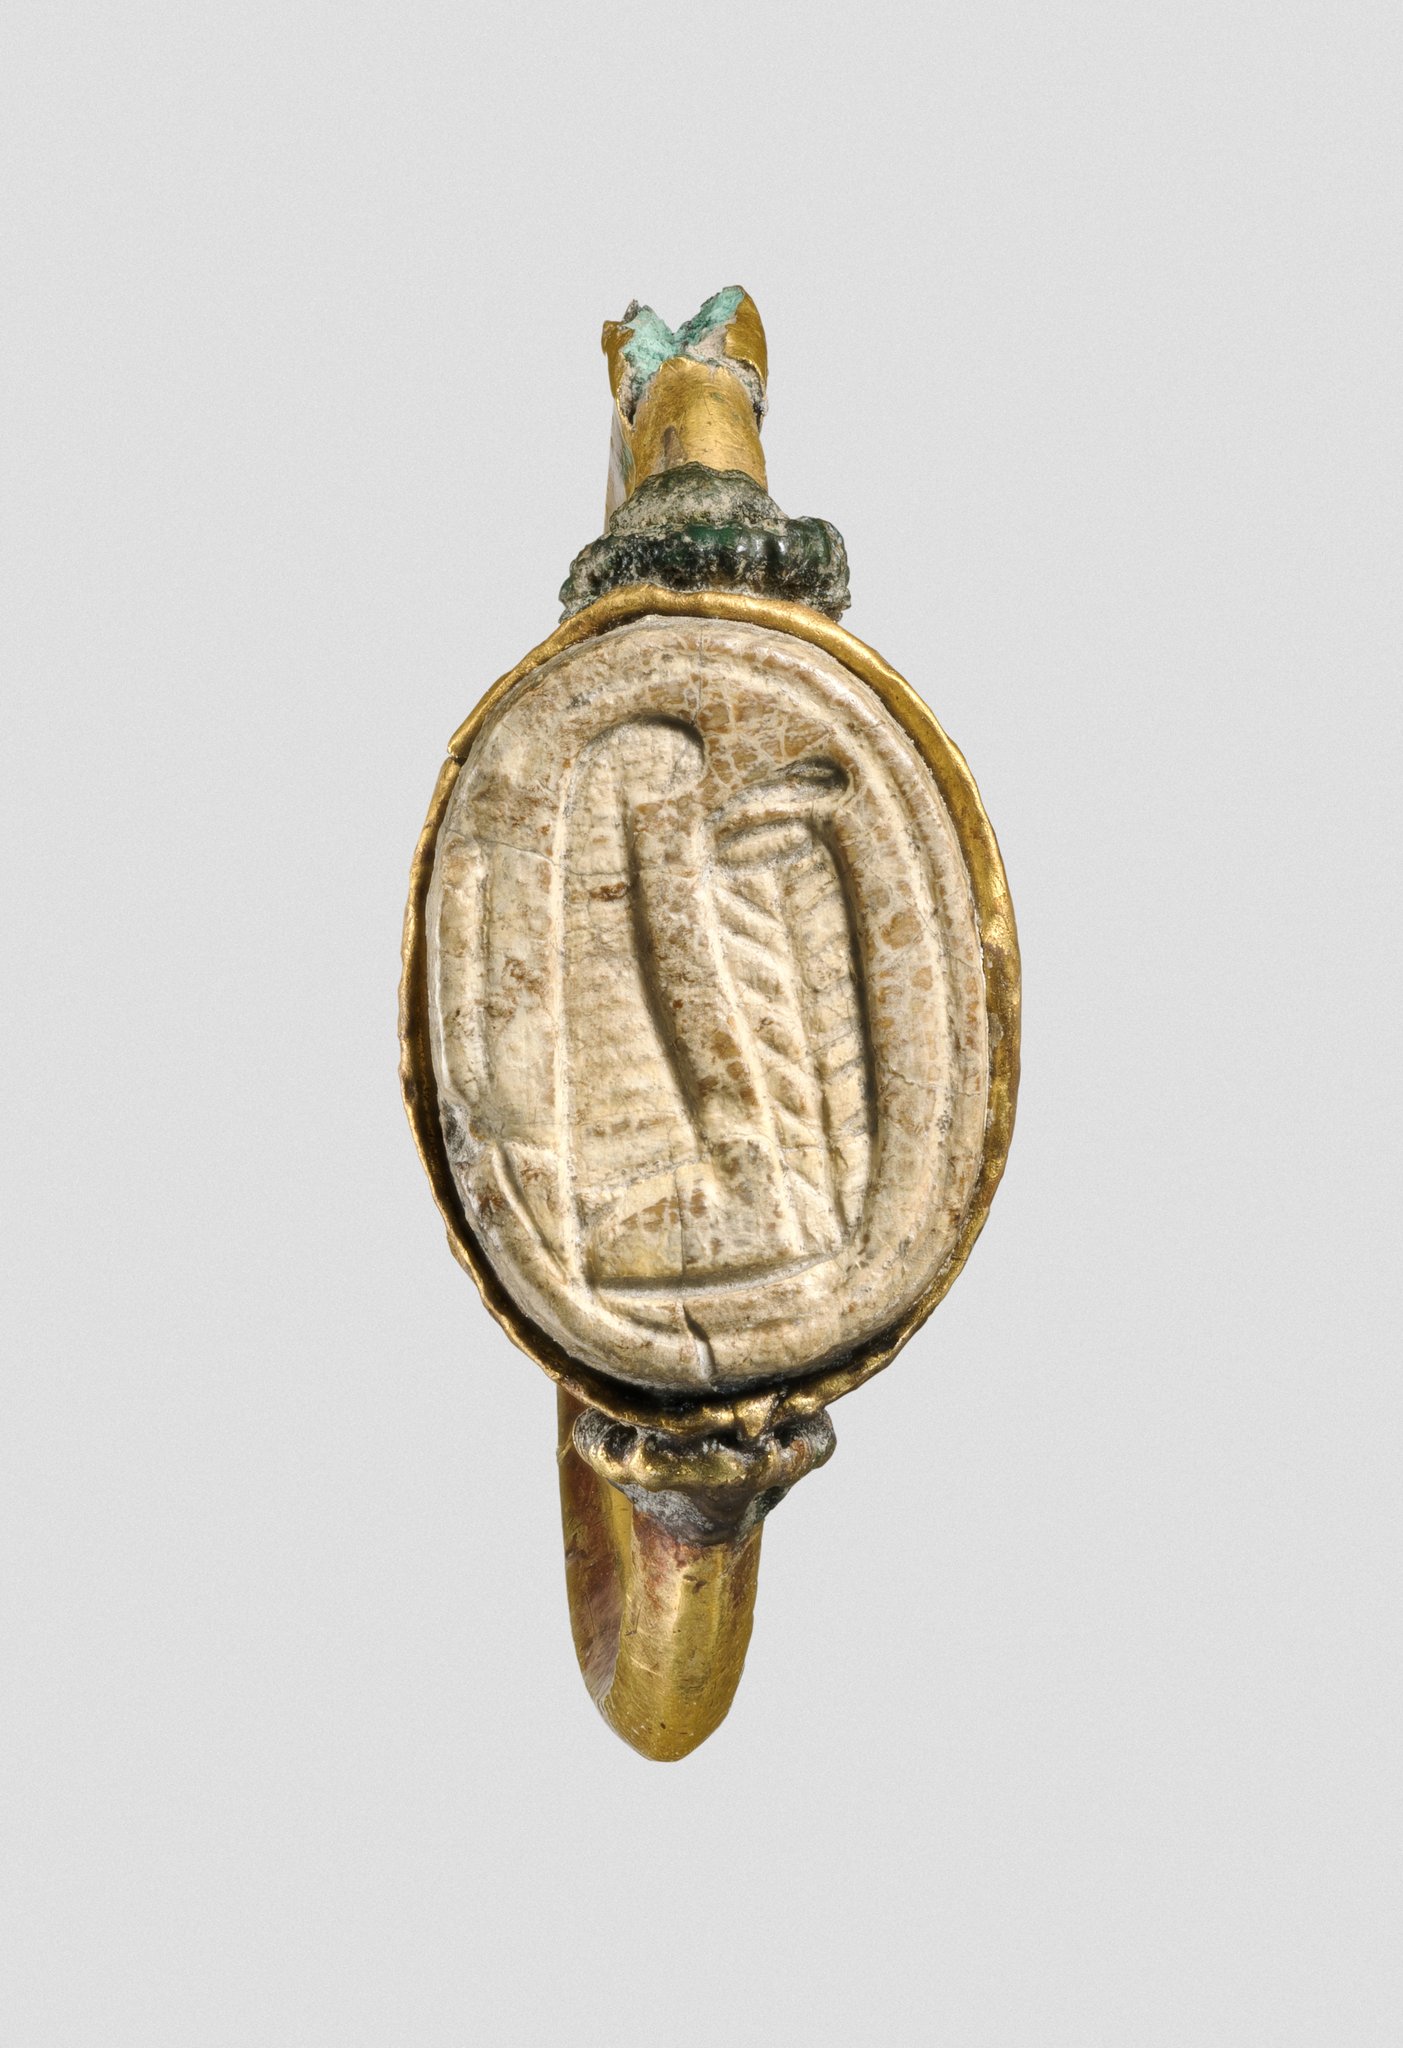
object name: ring with scarab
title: Gold ring with scarab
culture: cypriot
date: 800-501 BCE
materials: copper alloy, faience, gold, silver